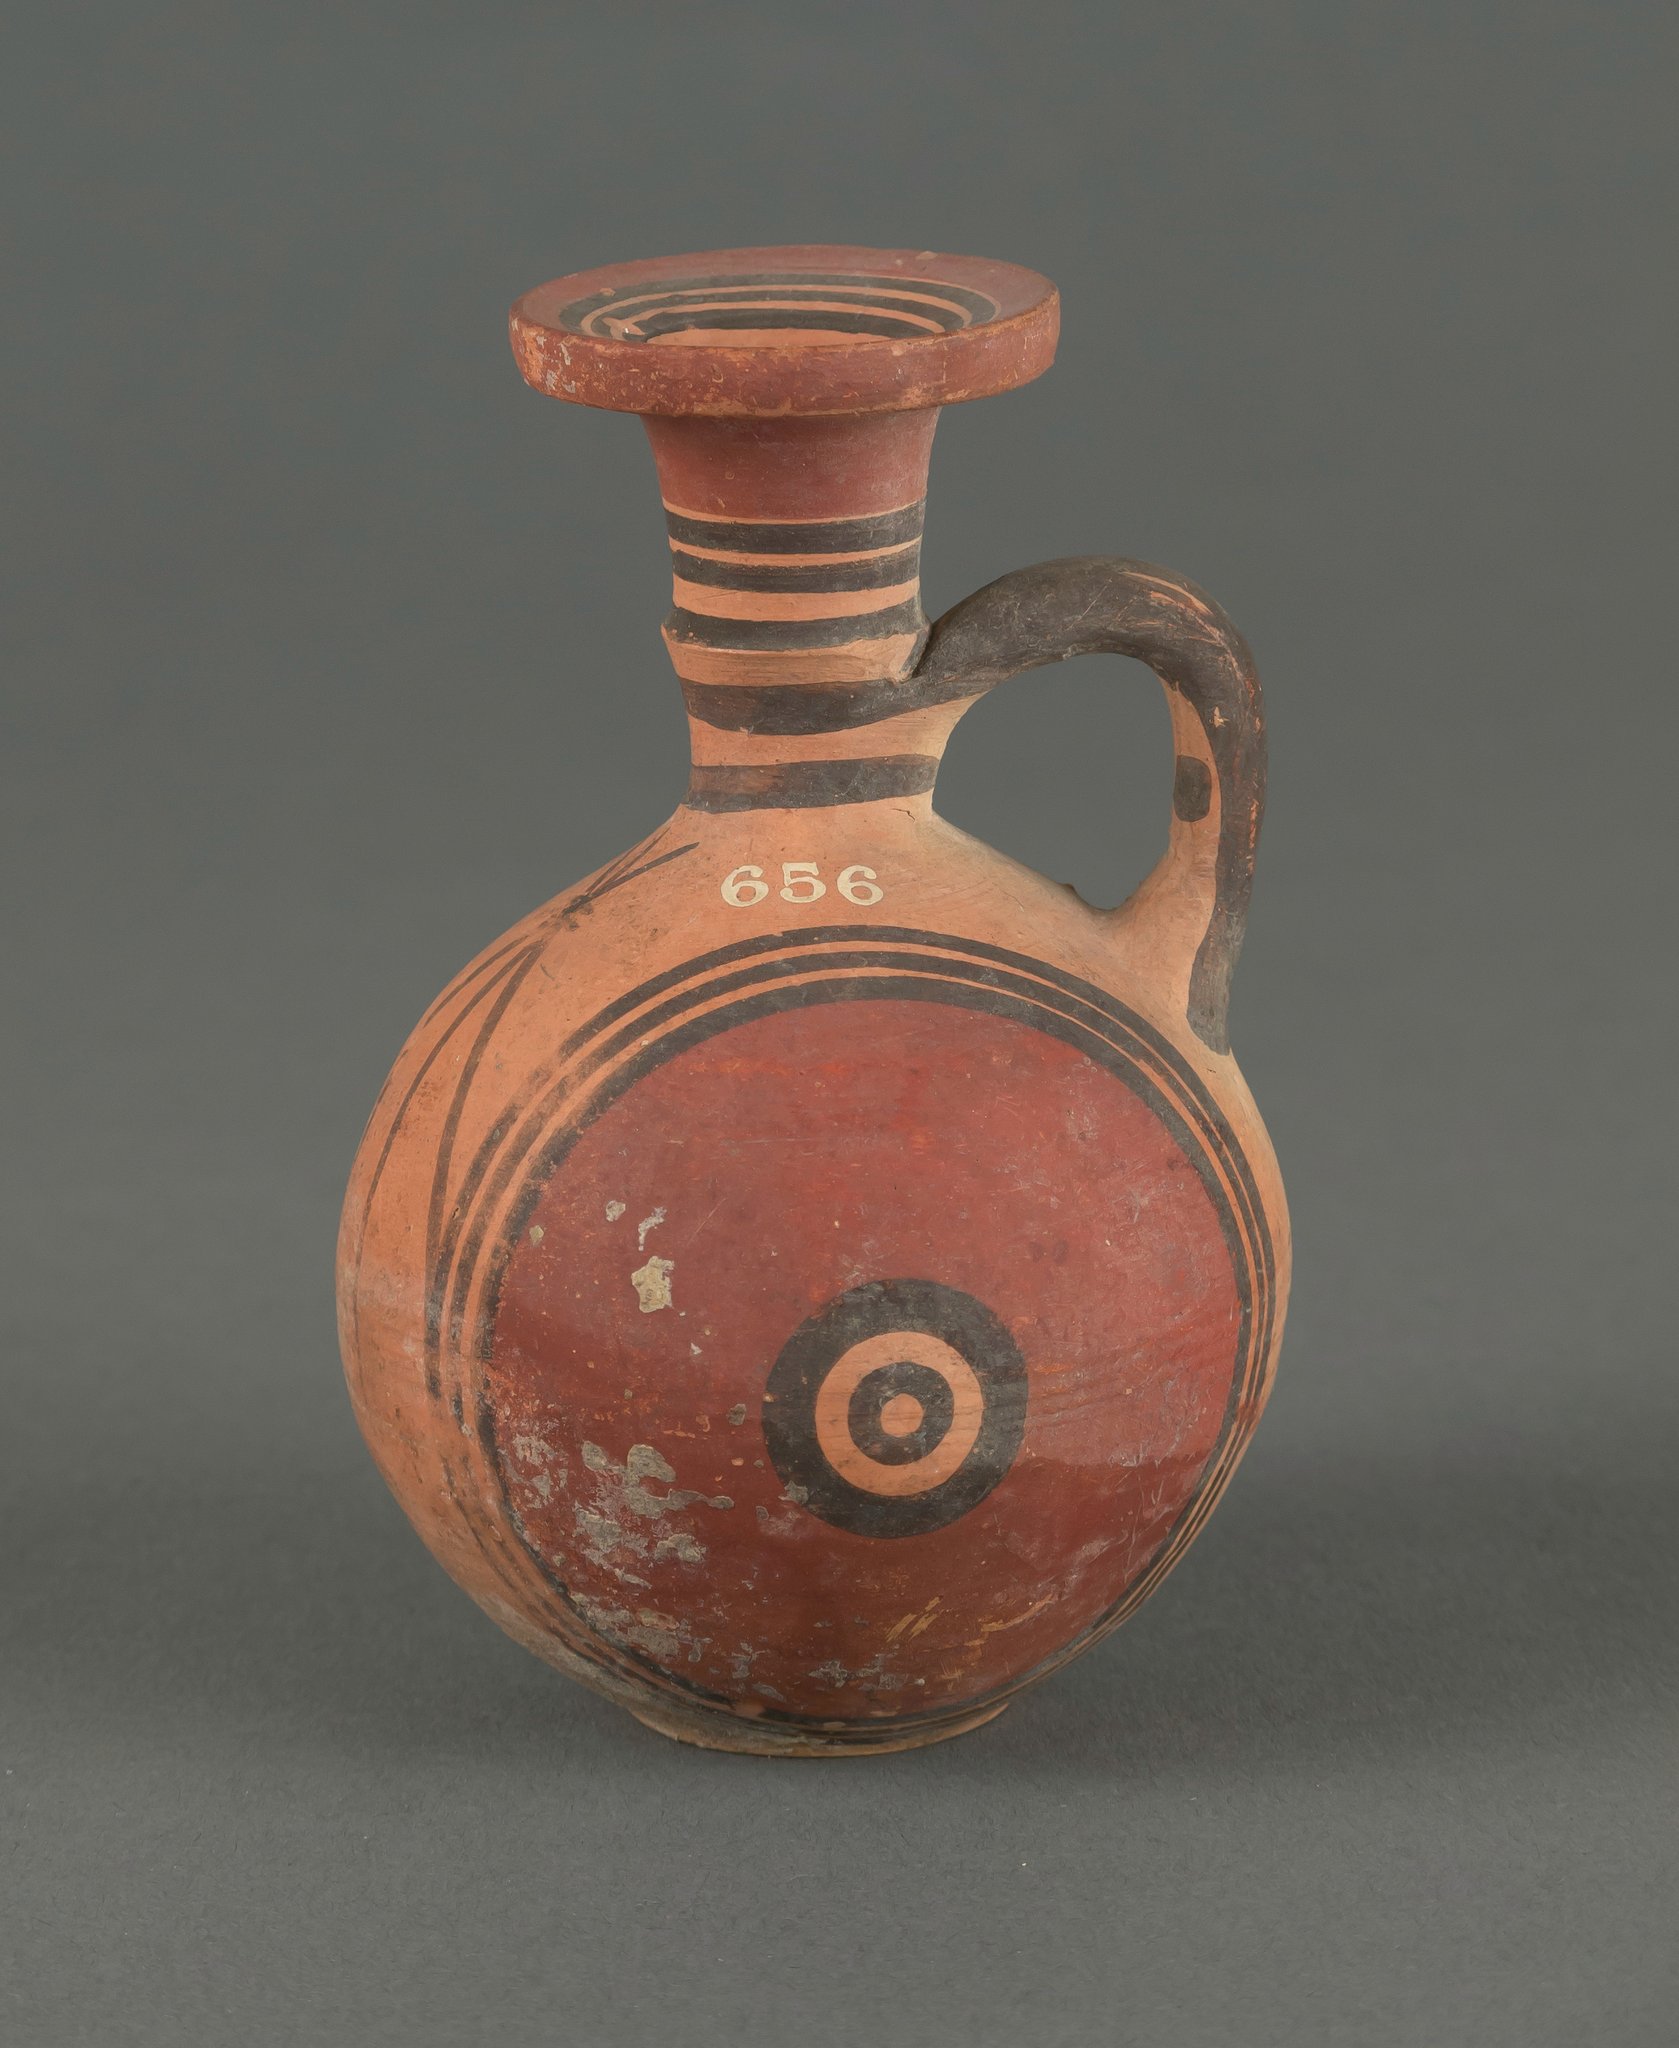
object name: juglet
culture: cypriot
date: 750-600 BCE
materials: terracotta